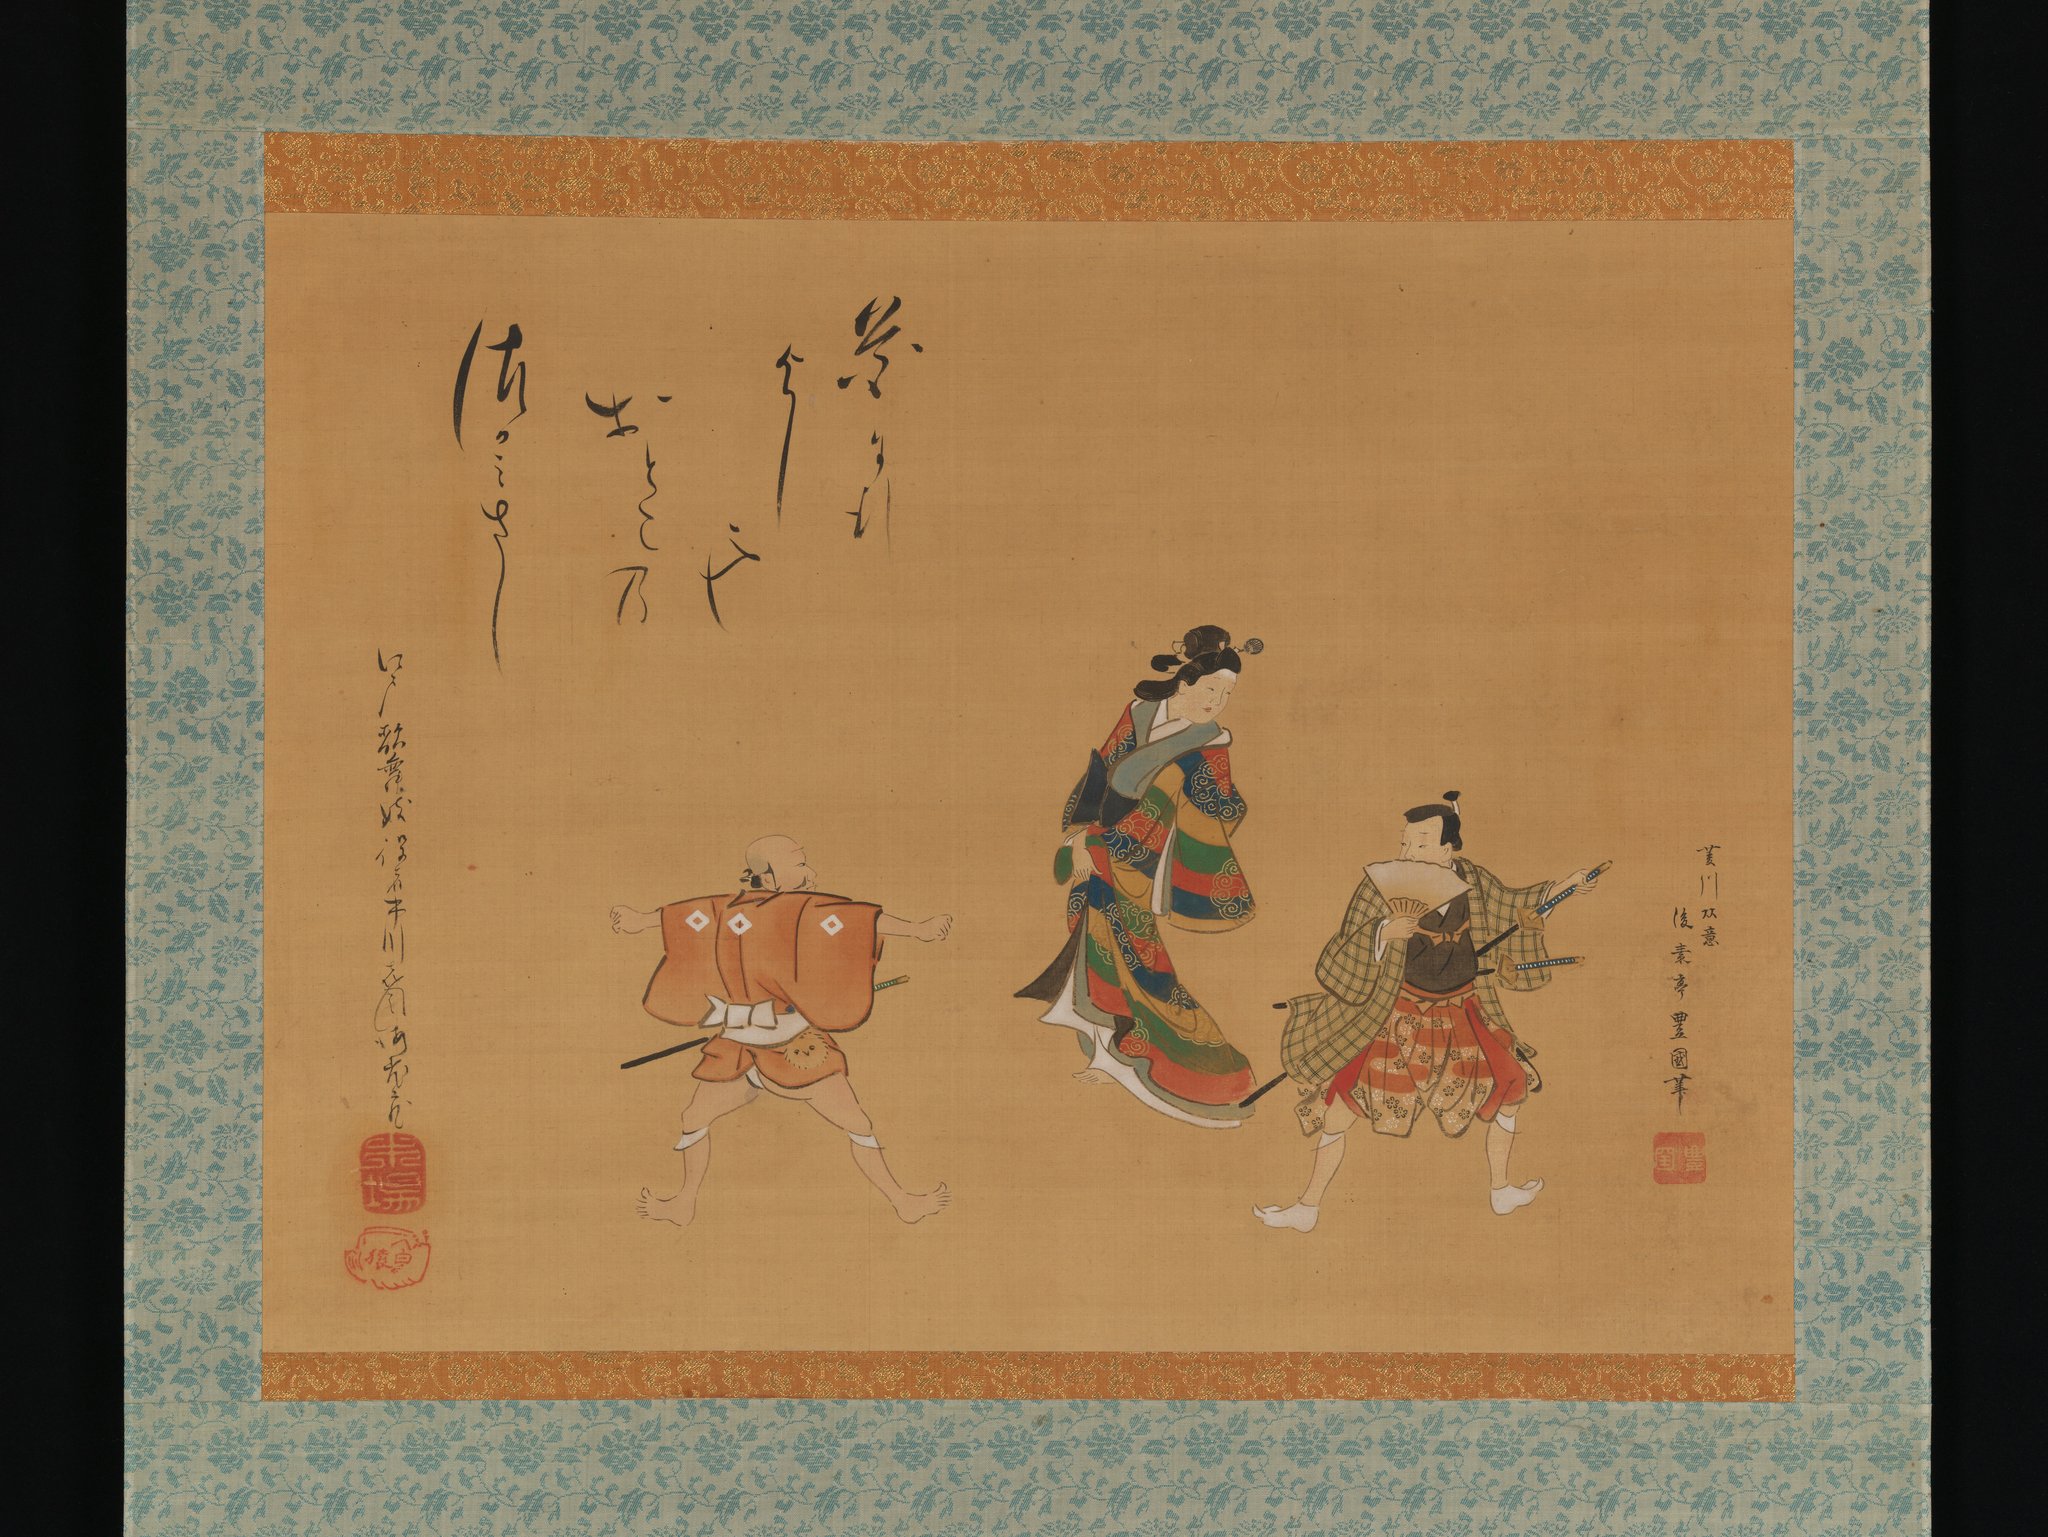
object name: hanging scroll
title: Fuwa Banzaemon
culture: japanese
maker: utagawa toyokuni ii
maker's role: artist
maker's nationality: japanese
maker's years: 1777-1835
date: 1801-1900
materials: ink, silk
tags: men,women